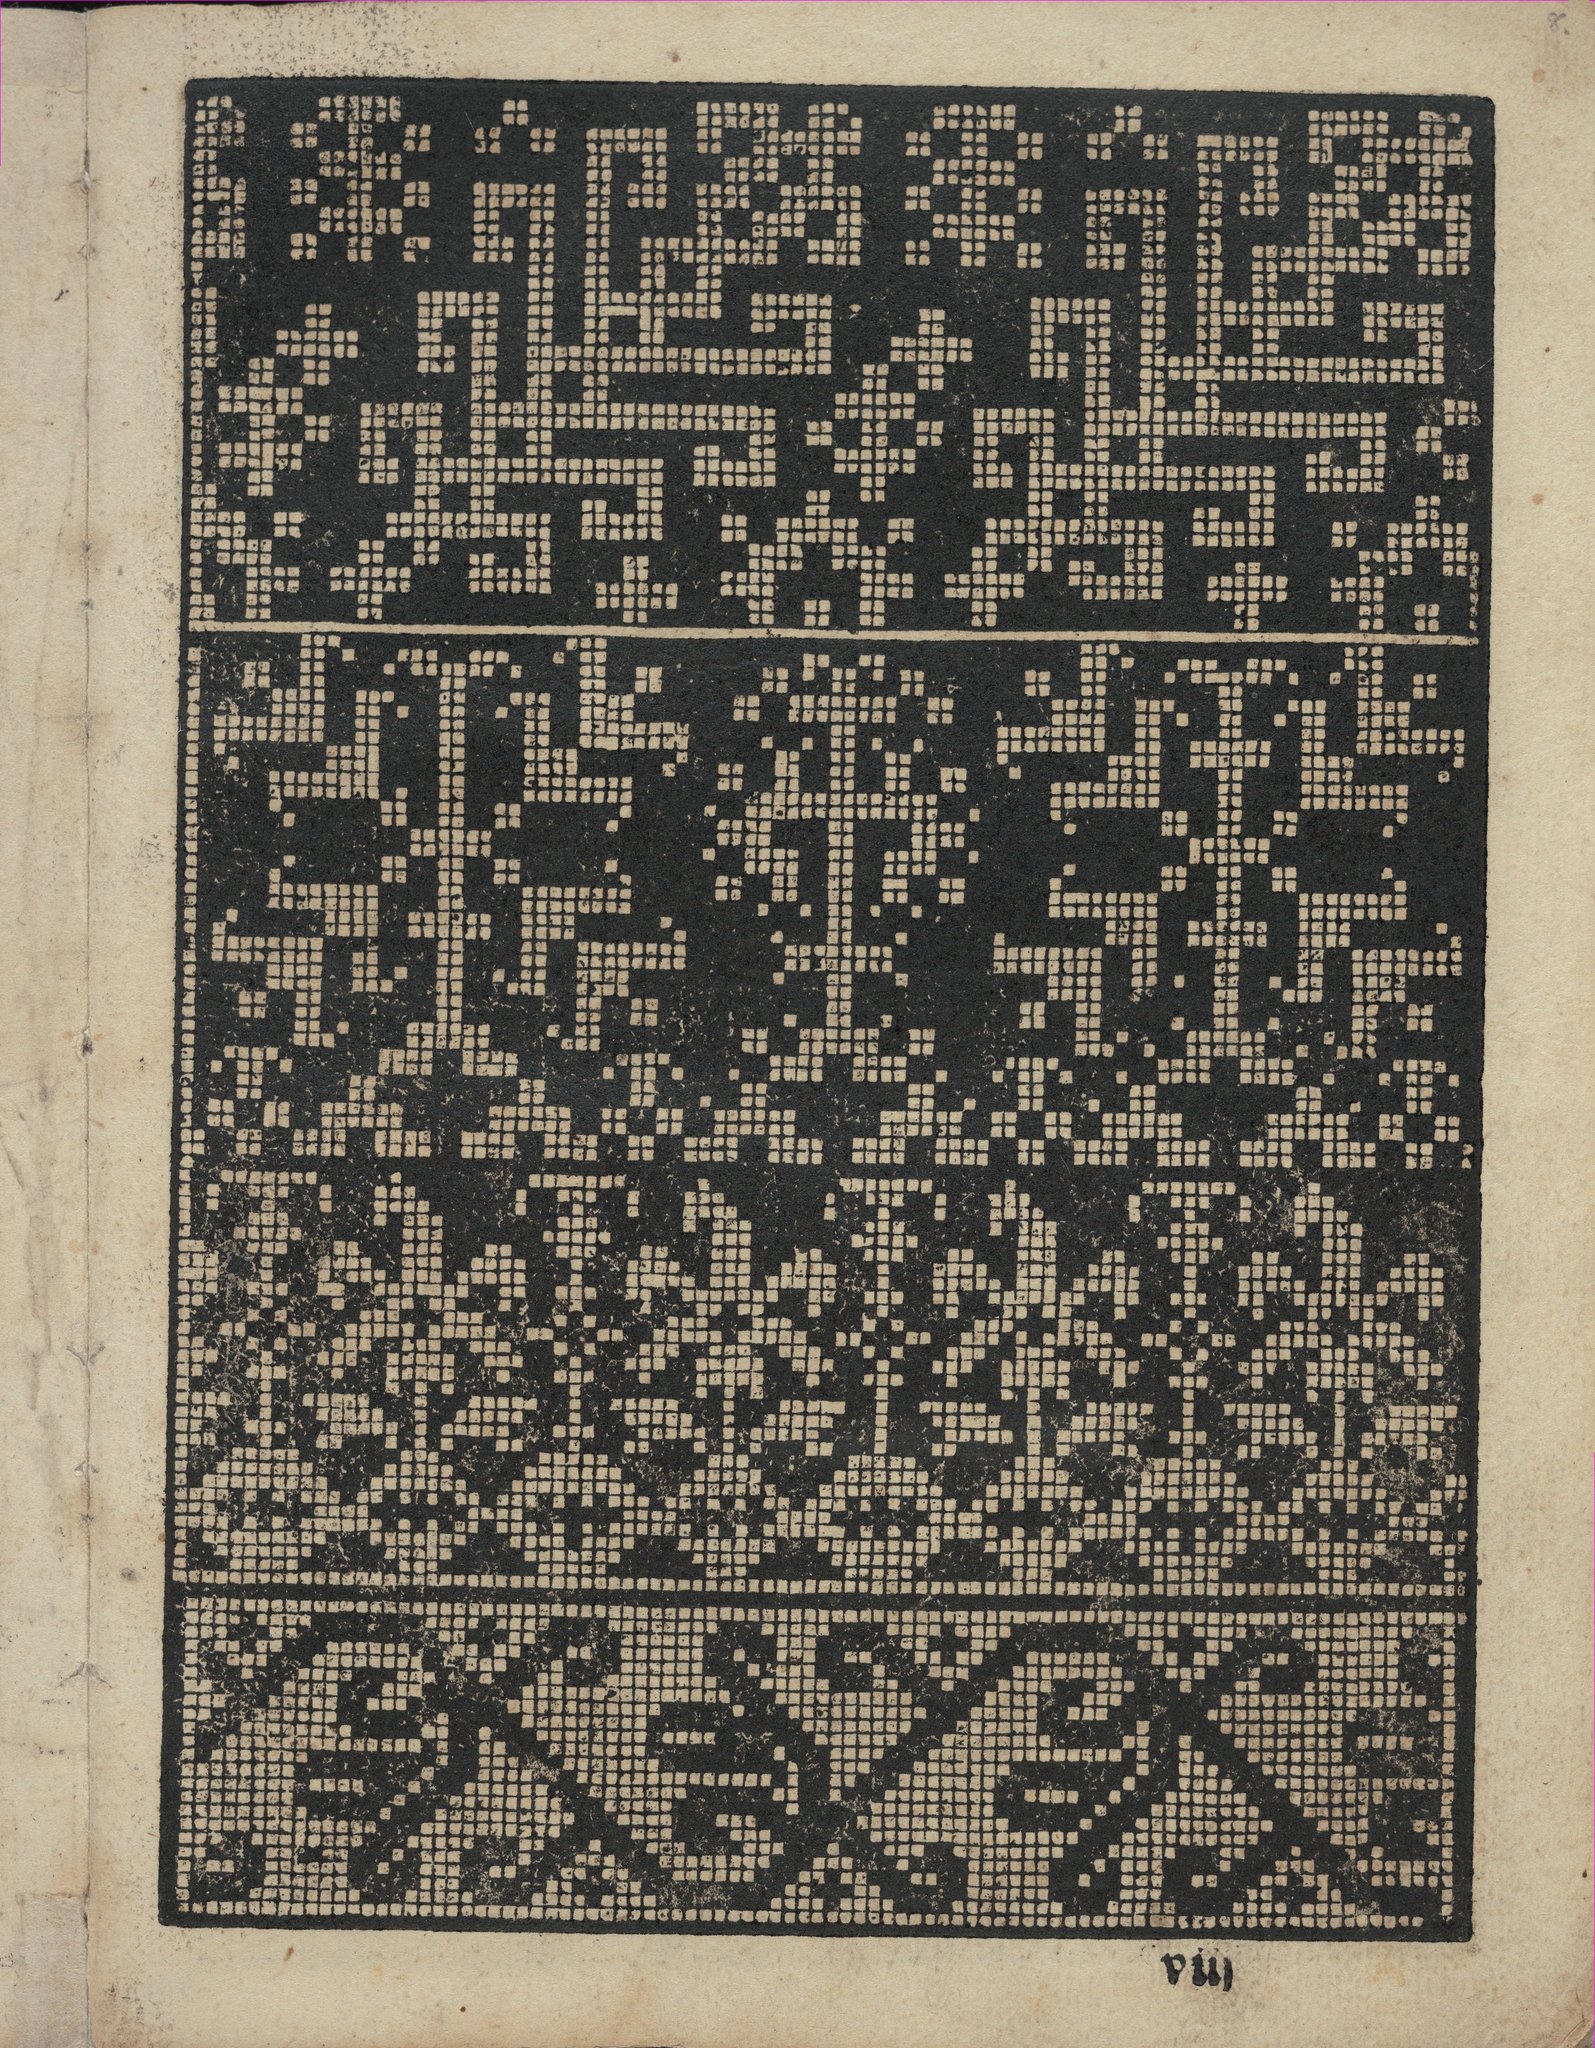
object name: book print ornament architecture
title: Libbretto nouellamete composto per maestro Domenico da Sera...lauorare di ogni sorte di punti, page 8 (recto)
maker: domenico da sera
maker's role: publisher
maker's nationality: french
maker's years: 1500-1599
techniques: woodcut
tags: ornament